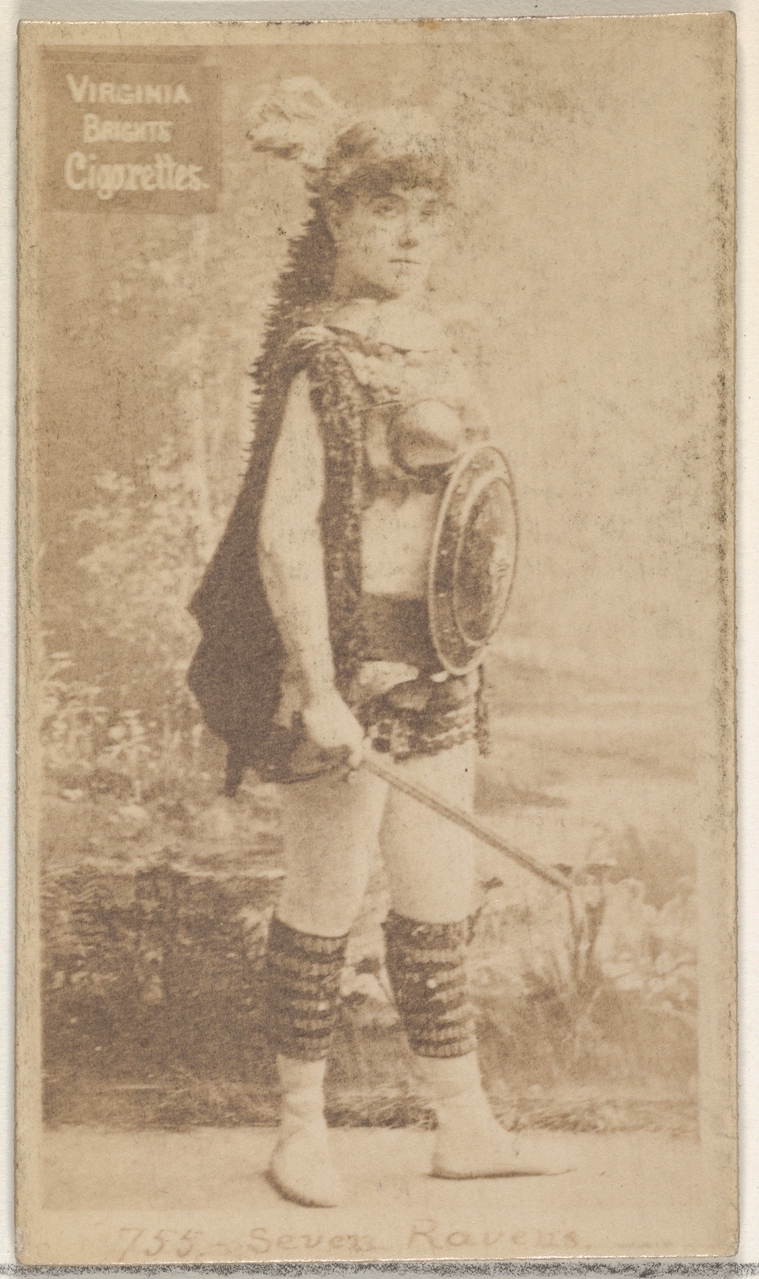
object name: photograph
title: Card 755, Seven Ravens, from the Actors and Actresses series (N45, Type 2) for Virginia Brights Cigarettes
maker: allen & ginter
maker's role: publisher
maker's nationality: american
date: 1888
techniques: albumen silver print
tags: shields,portraits,women,actresses